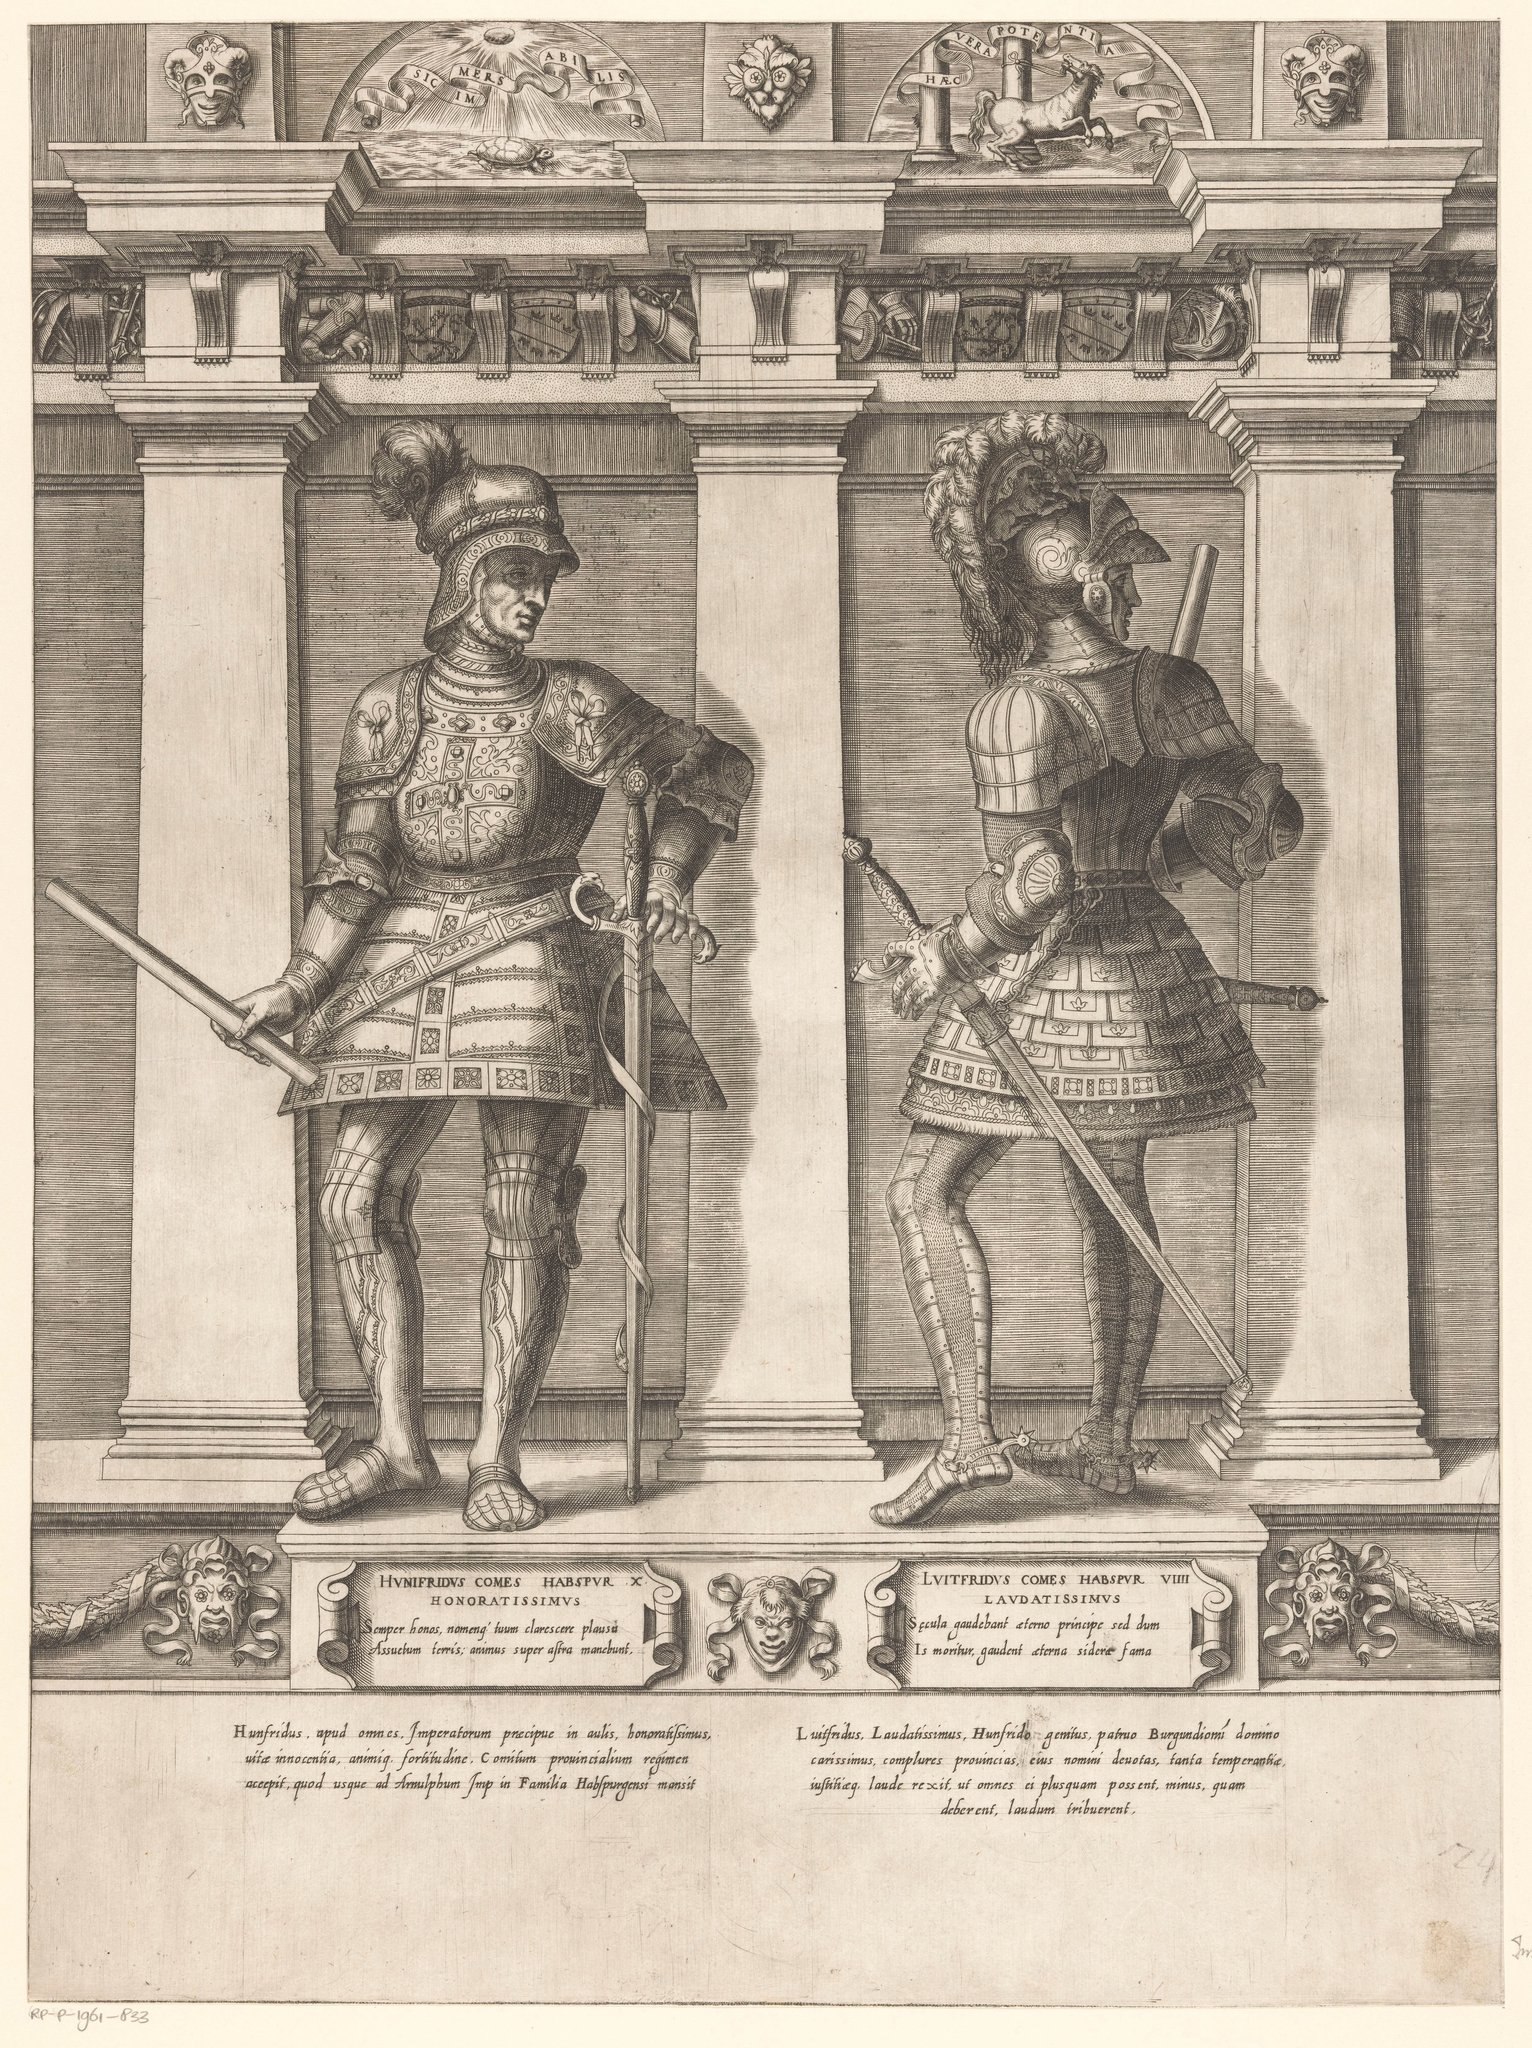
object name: print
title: Austriacae gentis imaginum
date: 1569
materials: paper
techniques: engraving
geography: italy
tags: historical persons, ruler, sovereign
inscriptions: collector's mark: Lugt 2228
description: Deze prent maakt deel uit van een reeks van 58 prenten. Het meerendeel van de prenten bevat portretten van 74 leden van het Oostenrijkse Huis, naar tekeningen door Francesco Terzio, die deels getekend zijn naar de 28 levensgrote bronzen beelden die rond de cenotaaf van Maximiliaan I in de Hofkirche te Innsbruck staan.